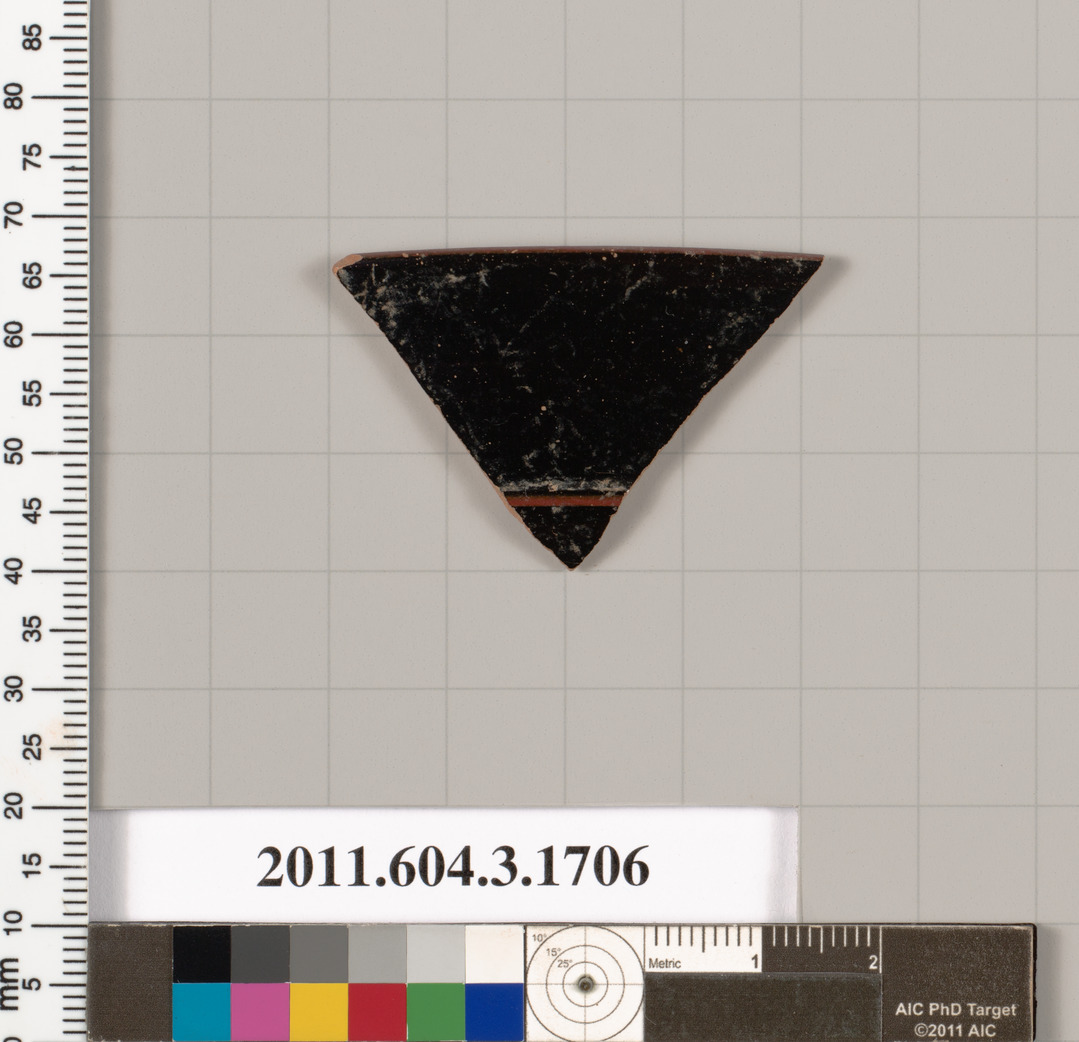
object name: kylix fragment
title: Terracotta rim fragment of a kylix: Band cup (drinking cup)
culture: greek, attic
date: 550-526 BCE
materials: terracotta